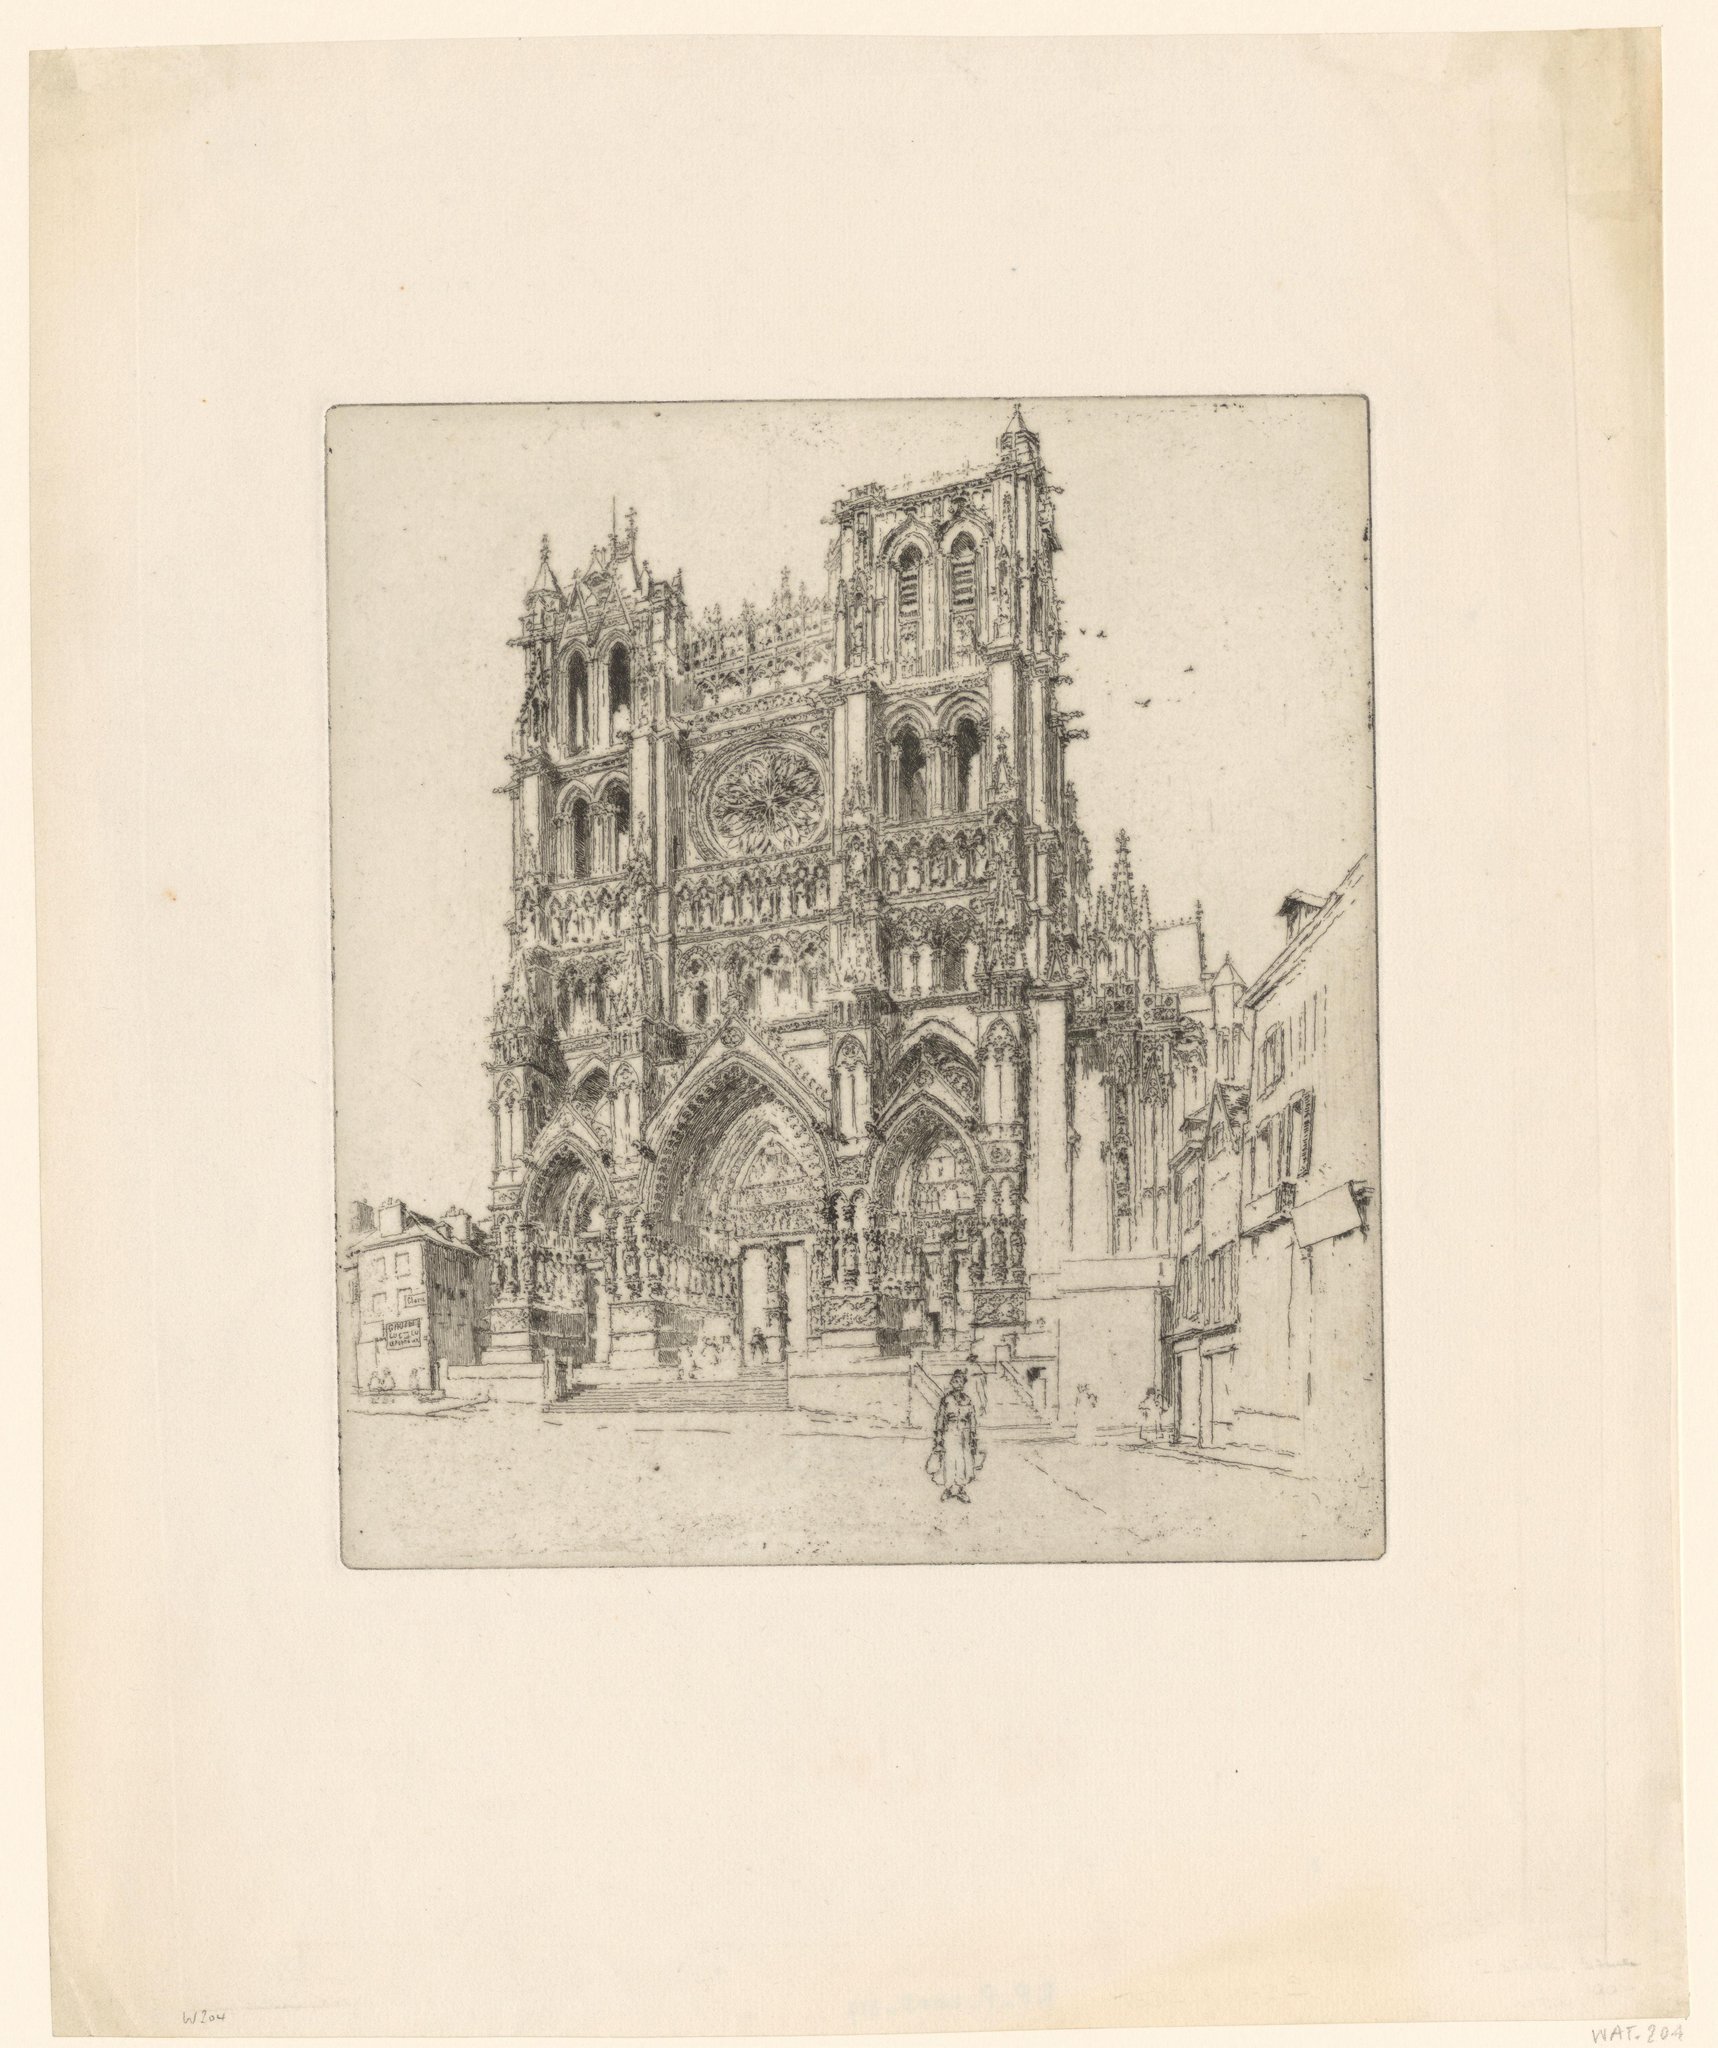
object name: print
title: Gezicht op de façade van de Notre-Dame van Amiens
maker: charles john watson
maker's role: print maker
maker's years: 1846-1927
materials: paper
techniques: etching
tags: parts of church exterior and annexes: façade, notre-dame d'amiens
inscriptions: collector's mark: Lugt 2228, collector's mark: Lugt 2760